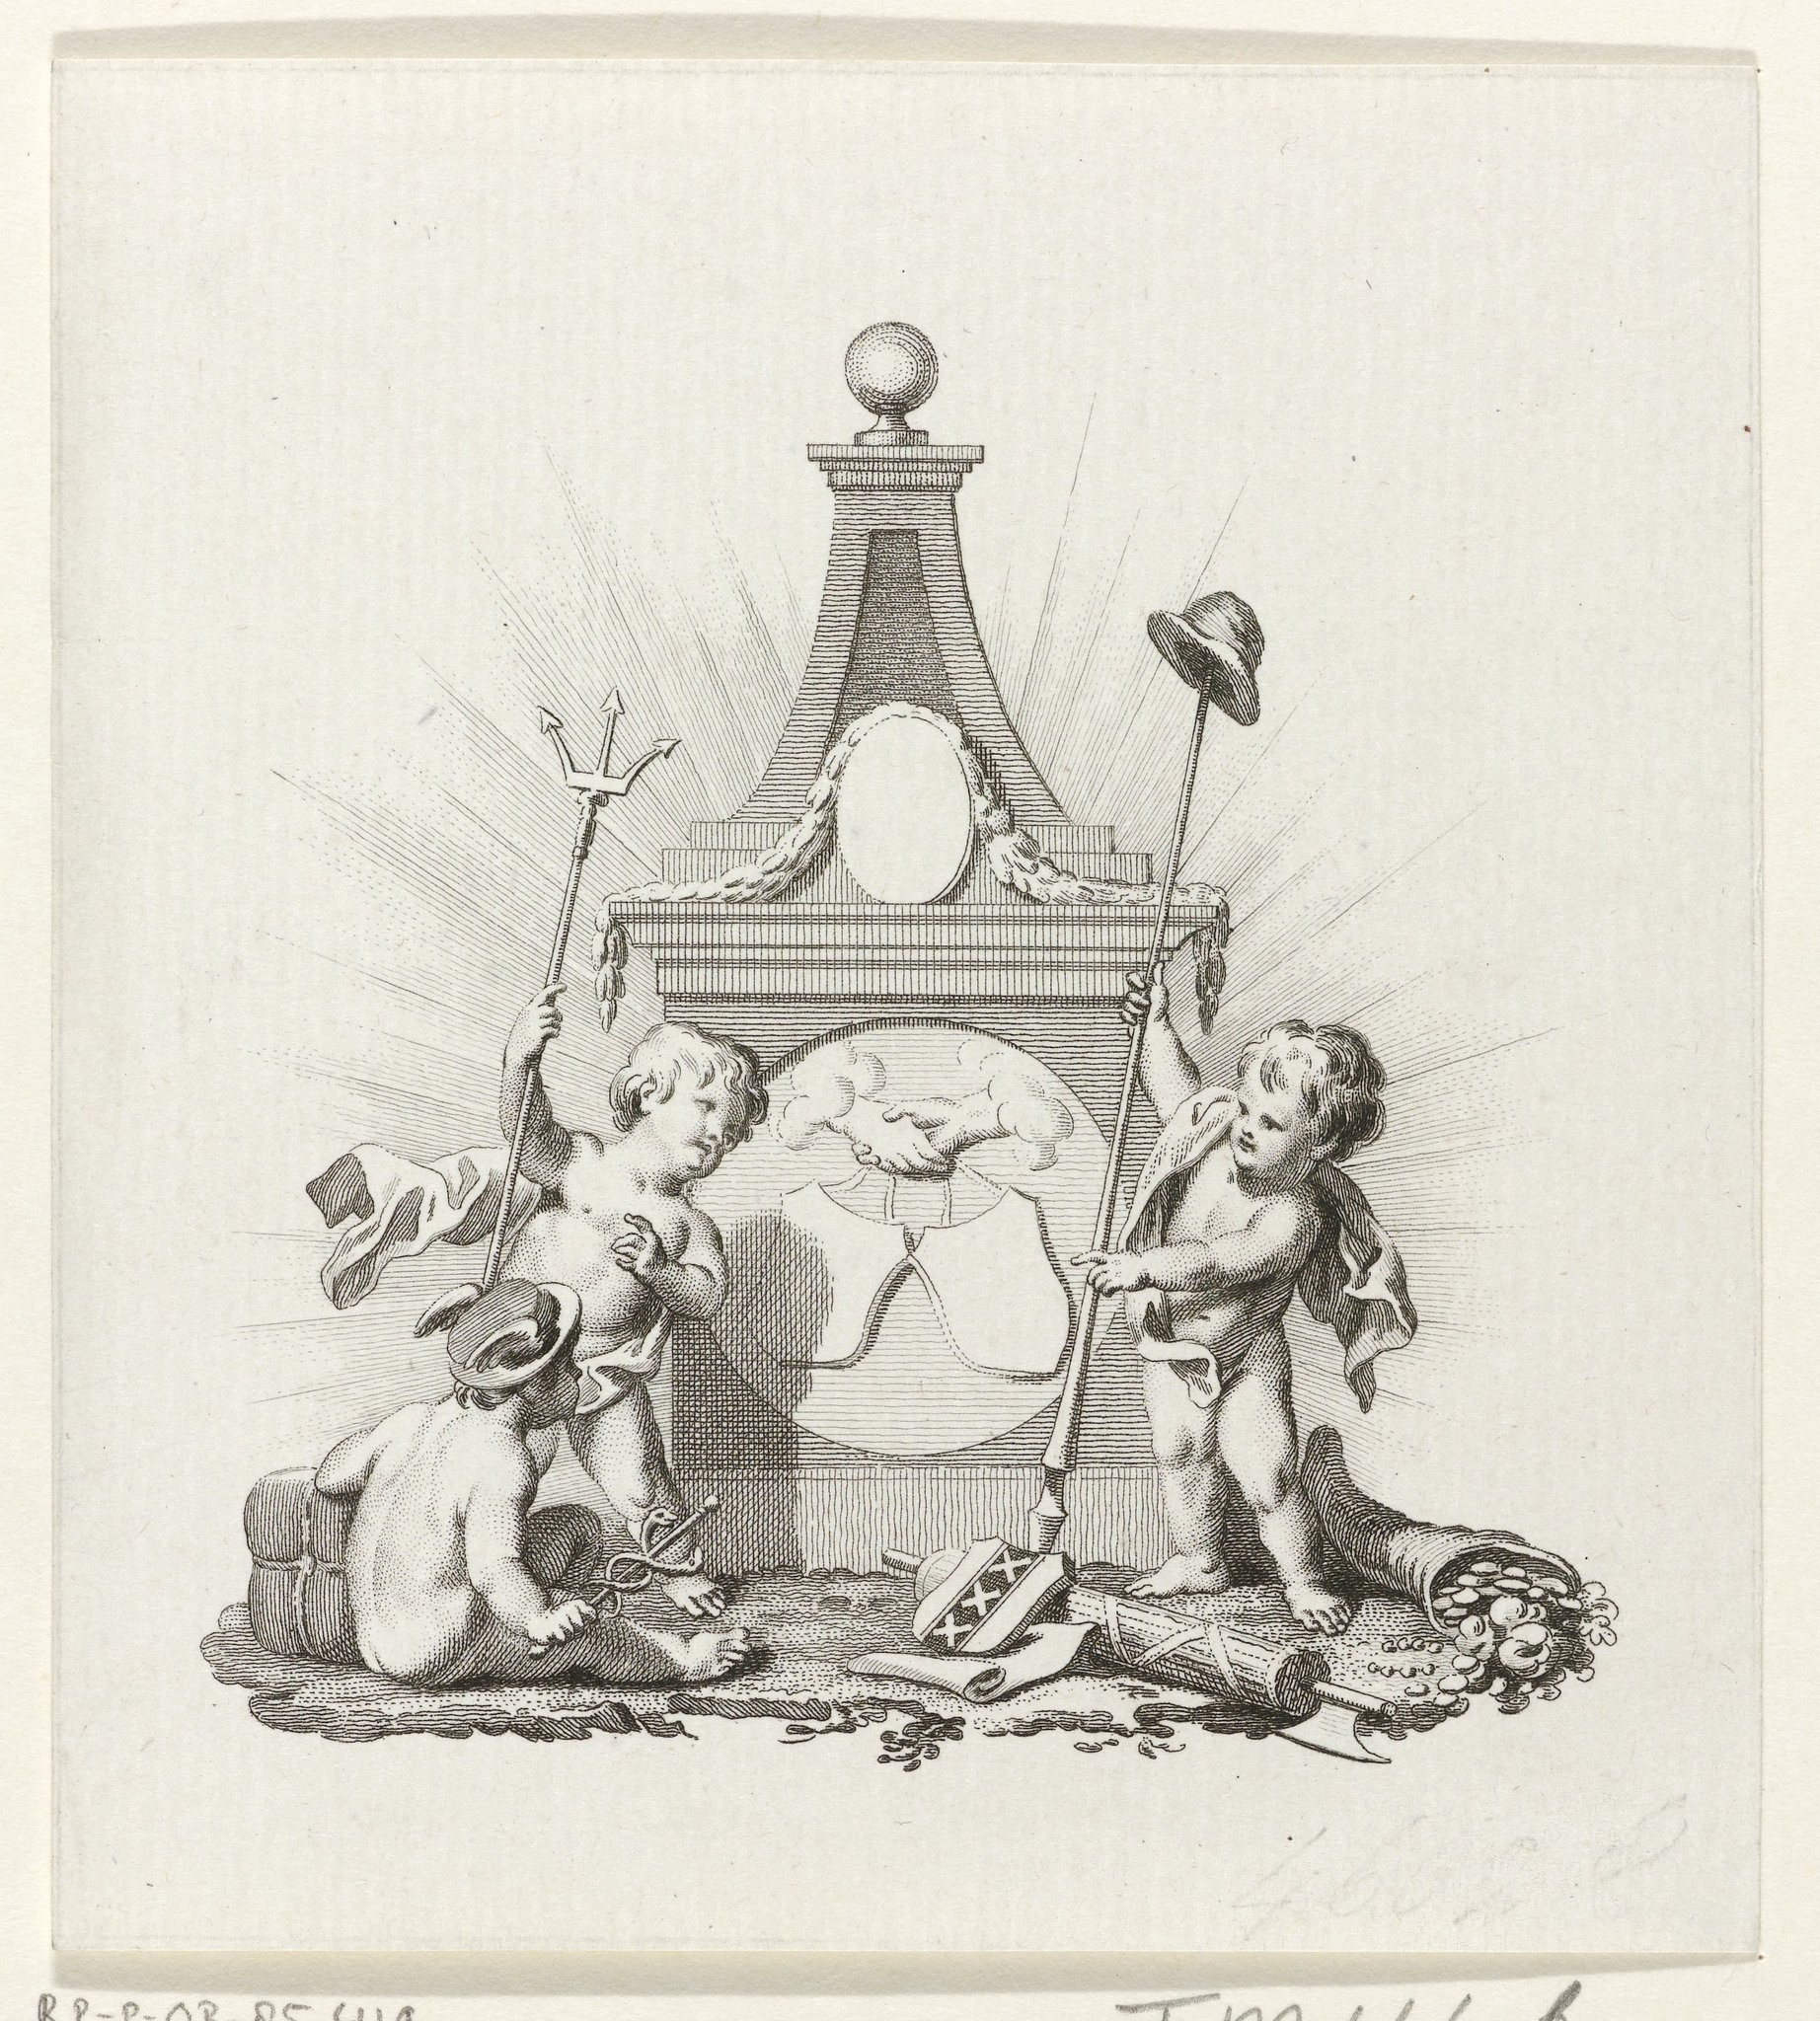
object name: titelblad, titelpagina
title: Titelpagina voor: Nederland in verbond met Frankrĳk. 10 november 1785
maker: reinier vinkeles (i)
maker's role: draughtsman, print maker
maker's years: 1741-1816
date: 1786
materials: paper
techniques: engraving, etching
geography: northern netherlands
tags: patriots (1780-1795)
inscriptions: collector's mark: Lugt 2228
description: Titelpagina voor: Nederland in verbond met Frankrĳk. 10 november 1785. Allegorisch vignet met geniussen bij een monument voor het verbond tussen de twee landen.